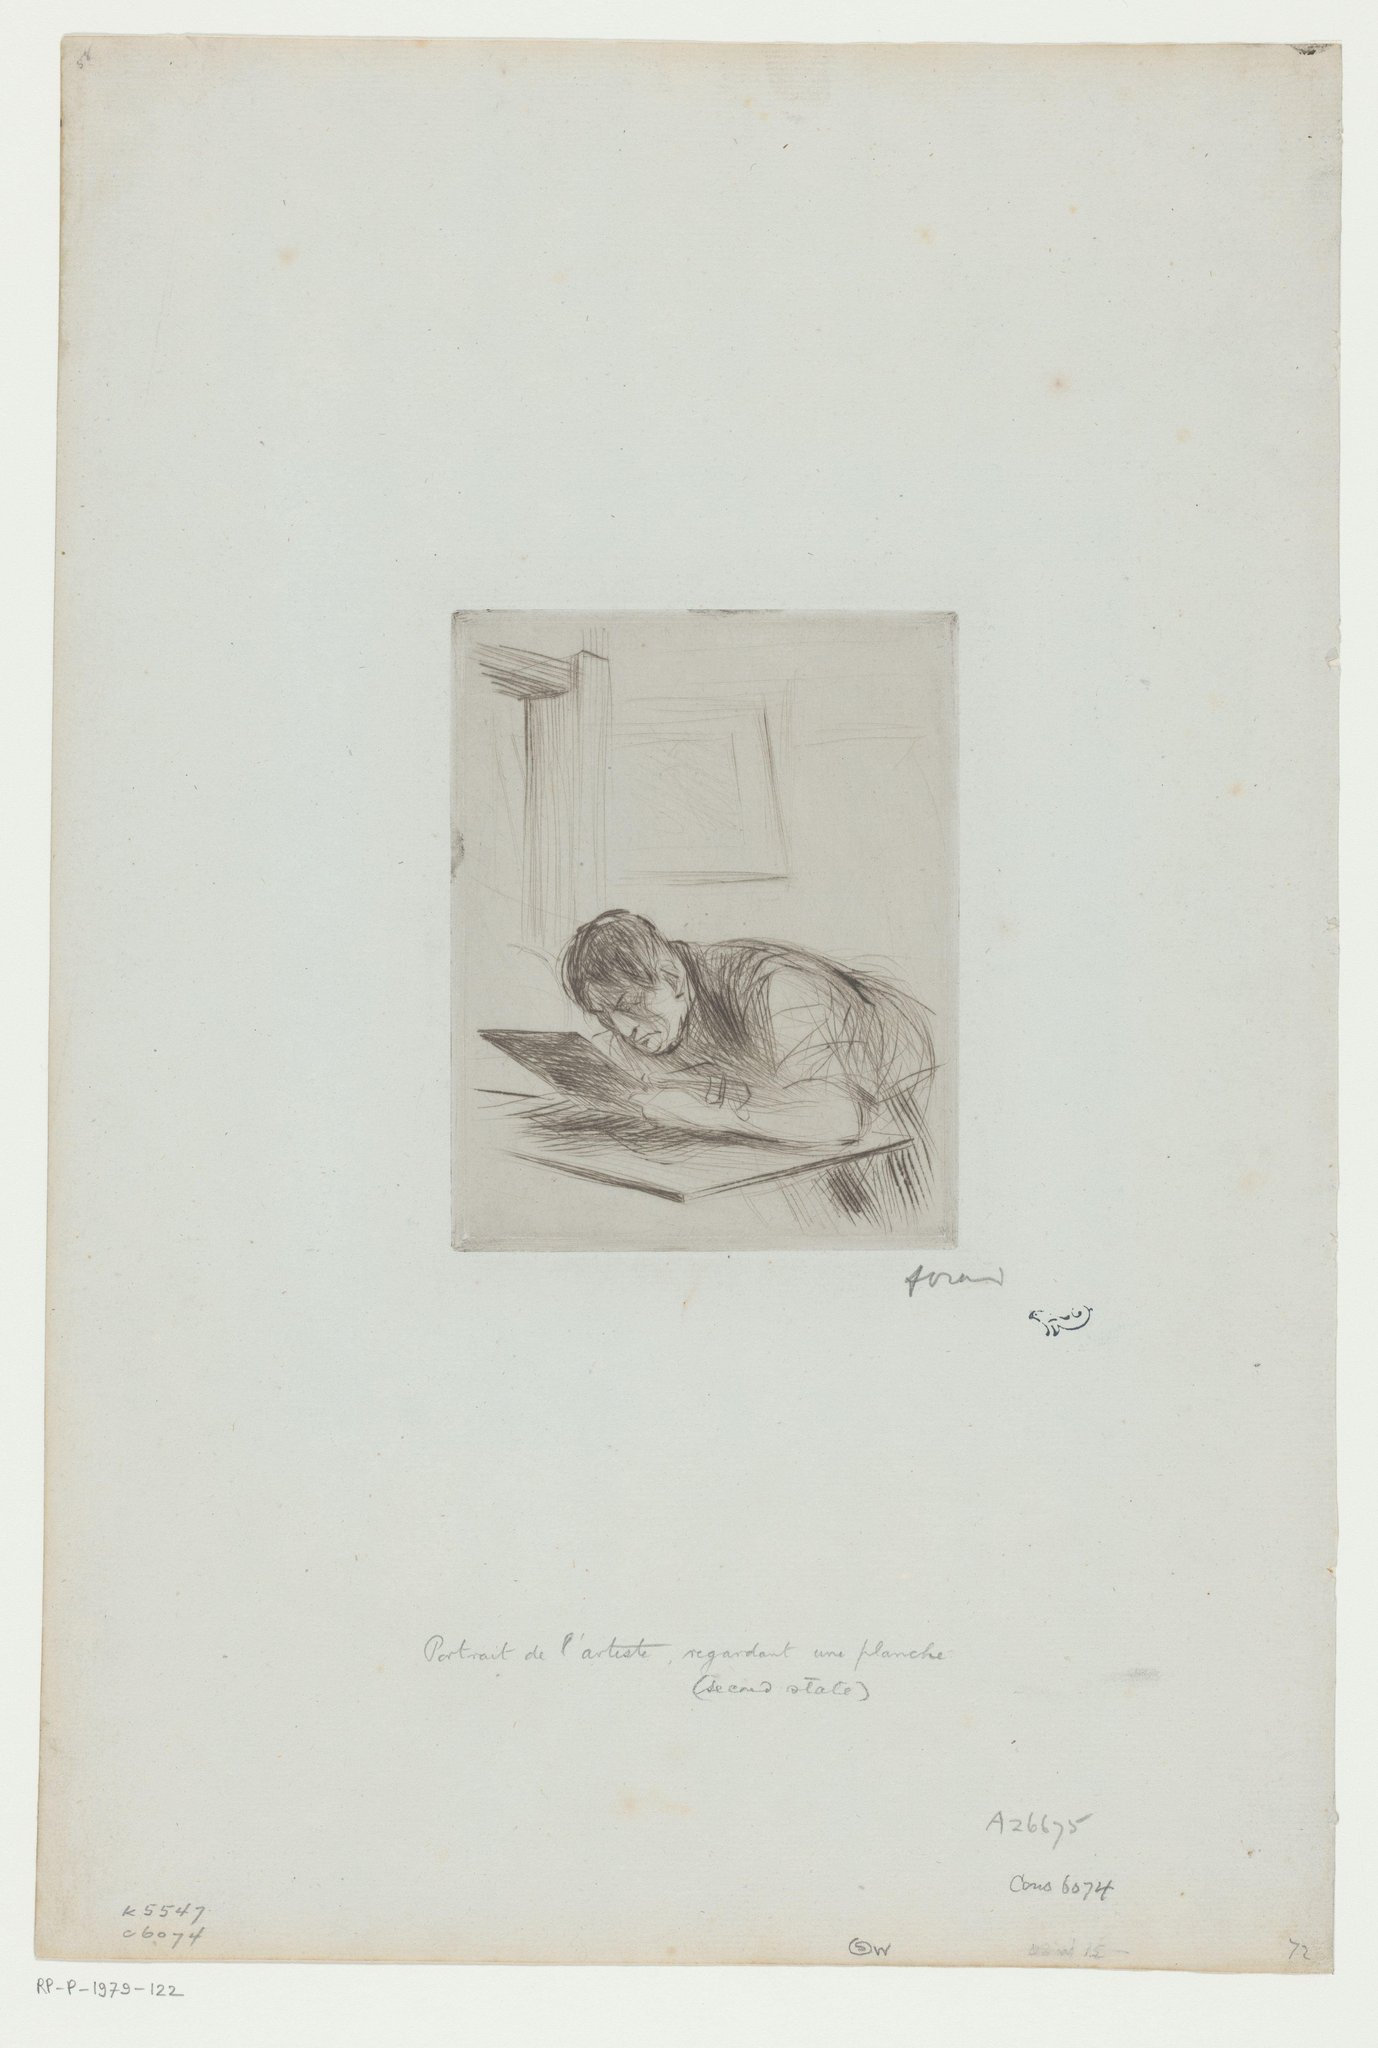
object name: print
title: Zelfportret van Jean-Louis Forain een etsplaat bekijkend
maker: jean-louis forain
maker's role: painter, print maker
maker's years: 1852-1931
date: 1862-1931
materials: paper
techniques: drypoint, intaglio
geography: france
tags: jean-louis forain, historical persons, portrait, self-portrait of artist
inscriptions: stamp: Lugt 2820a, collector's mark: Lugt 2760, collector's mark: Lugt 2228